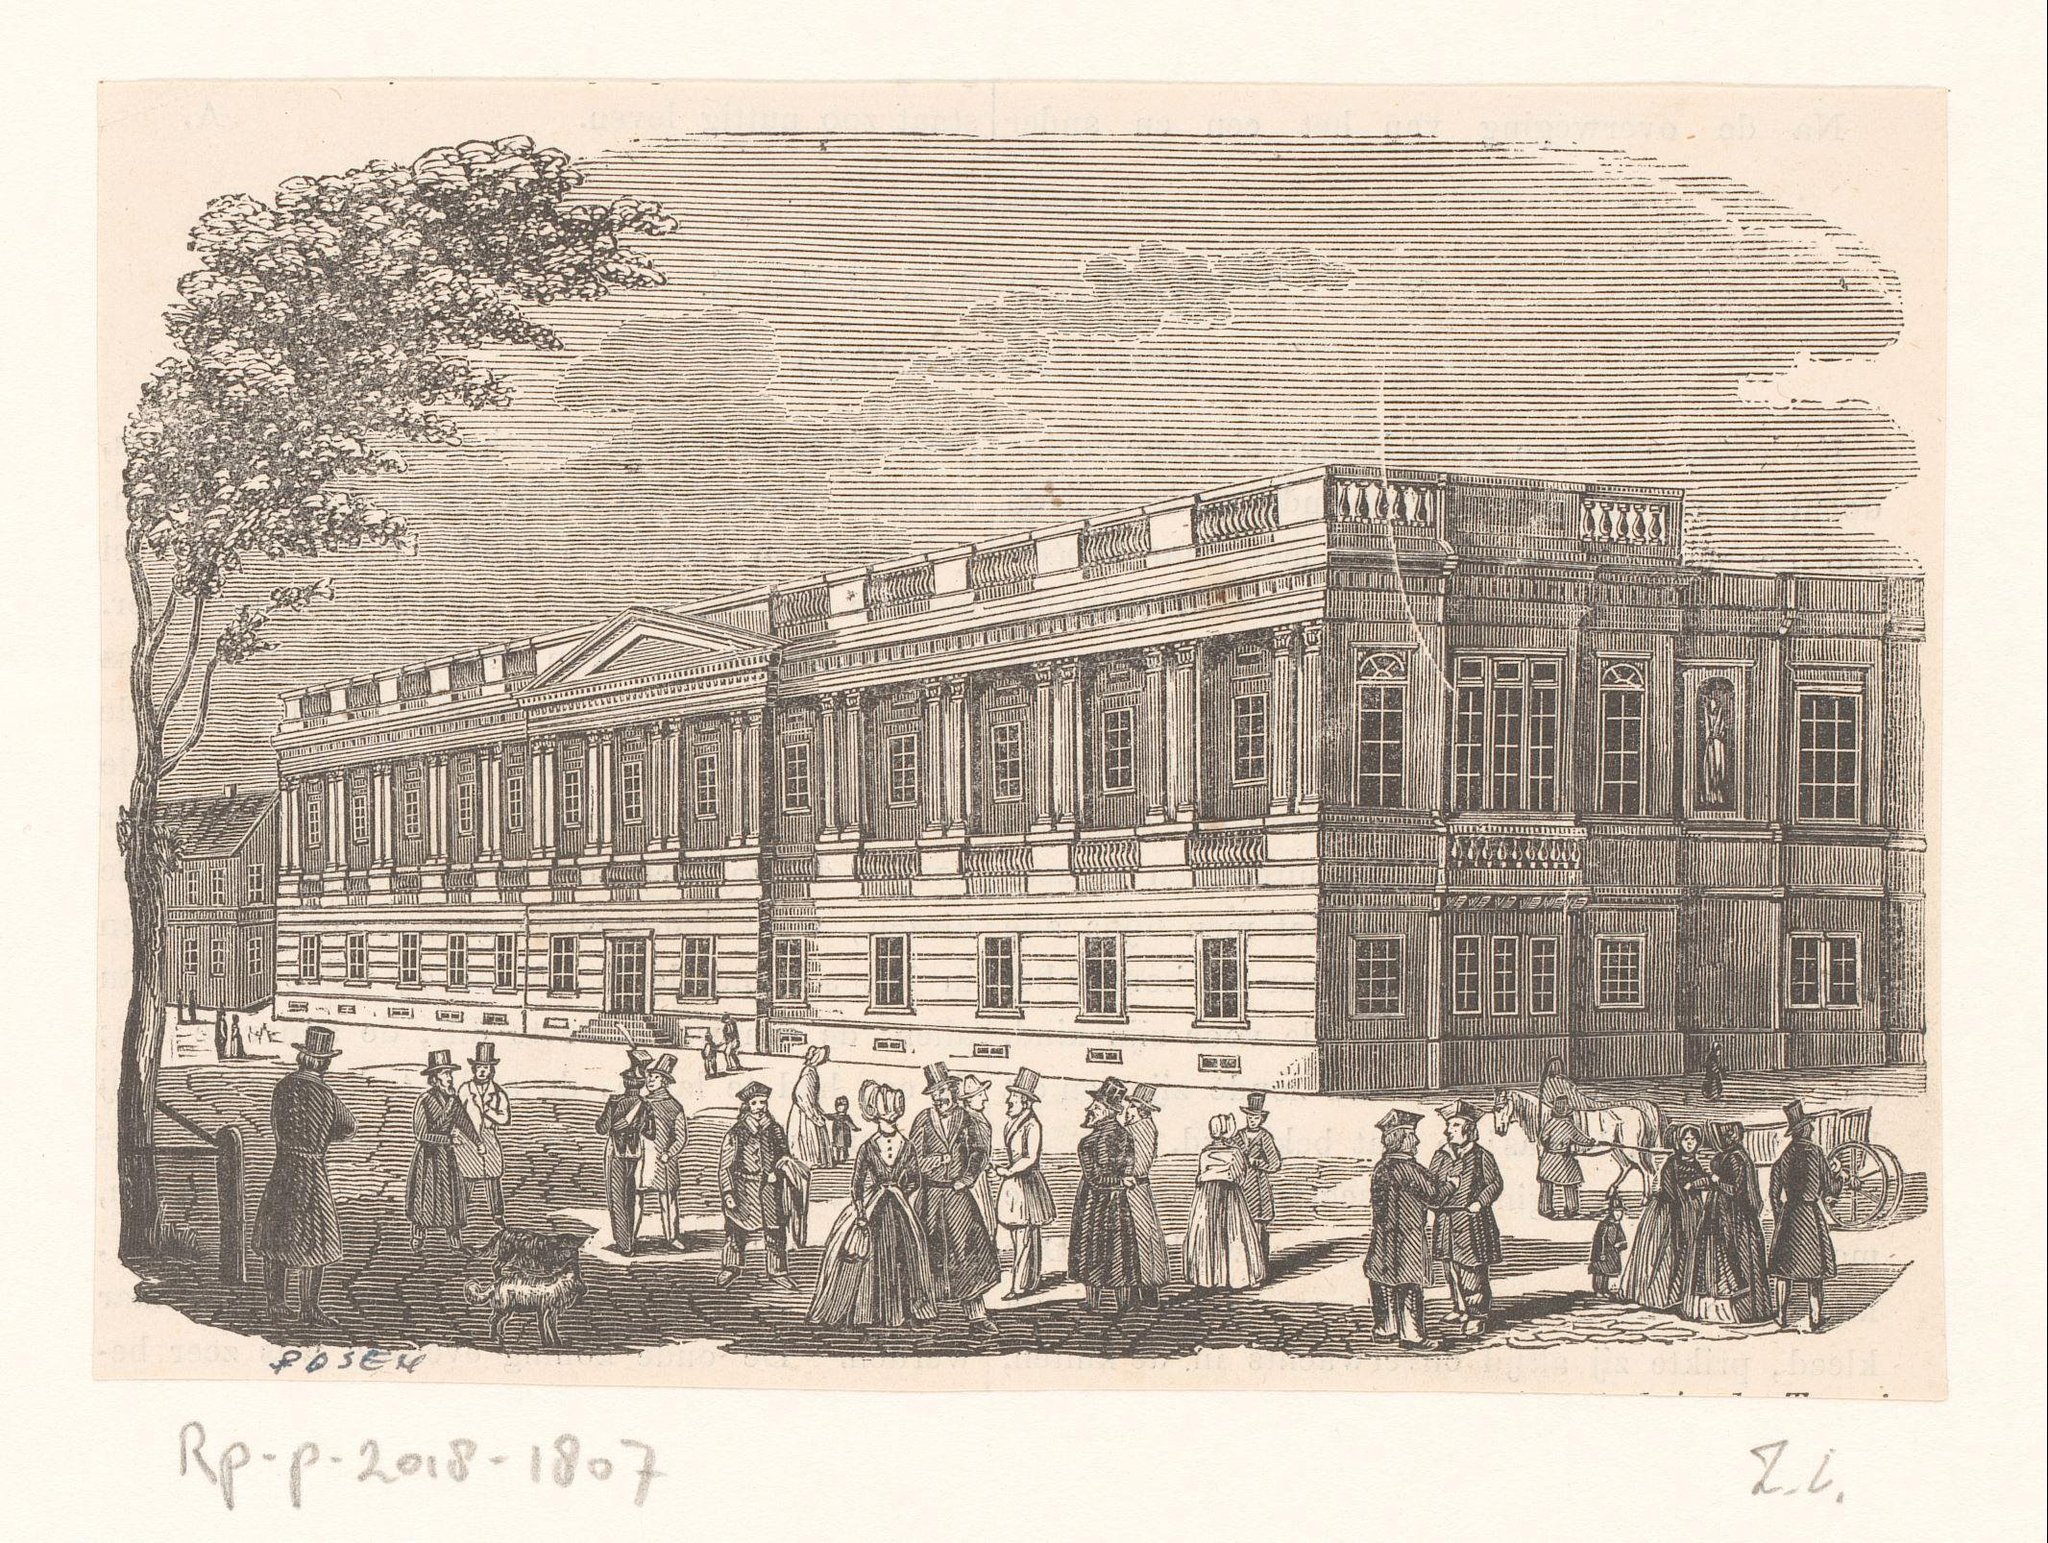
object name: print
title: Gezicht op de bibliotheek, te Poznań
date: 1847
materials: paper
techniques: letterpress printing, engraving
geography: amsterdam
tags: public library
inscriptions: collector's mark: Lugt 2228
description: Prent gebruikt in: Hollandsch Penning-Magazijn voor de jeugd. Amsterdam: J.H. Laarman, 1847.